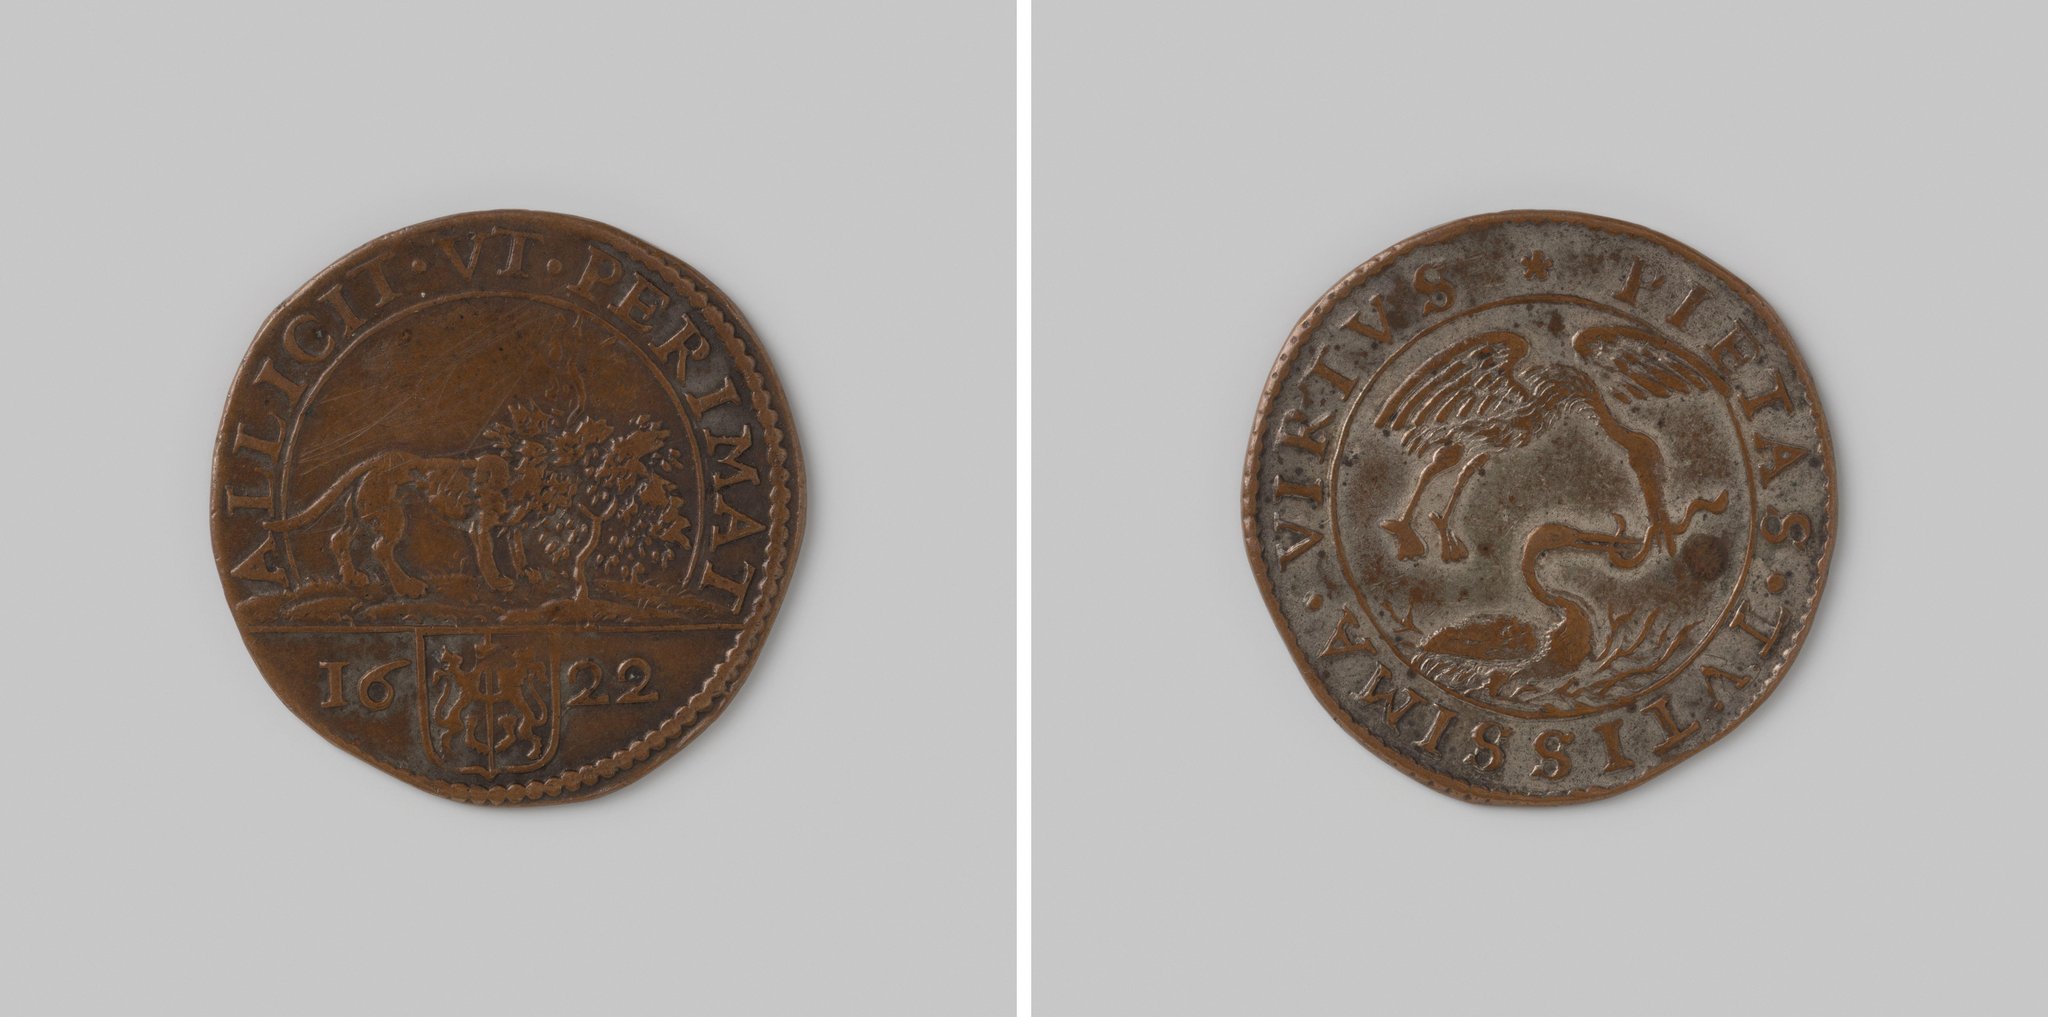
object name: jeton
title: Rekenpenning uit Gelderland op het opheffen van het beleg van Bergen op Zoom 1622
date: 1622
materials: copper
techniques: striking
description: Verzilverde penning, op de voorzijde een leeuw naar rechts die druiven van een struik eet, met omschrift en afsnedetekst, op de keerzijde een ooievaar die zijn jong een slang voert, met omschrift.